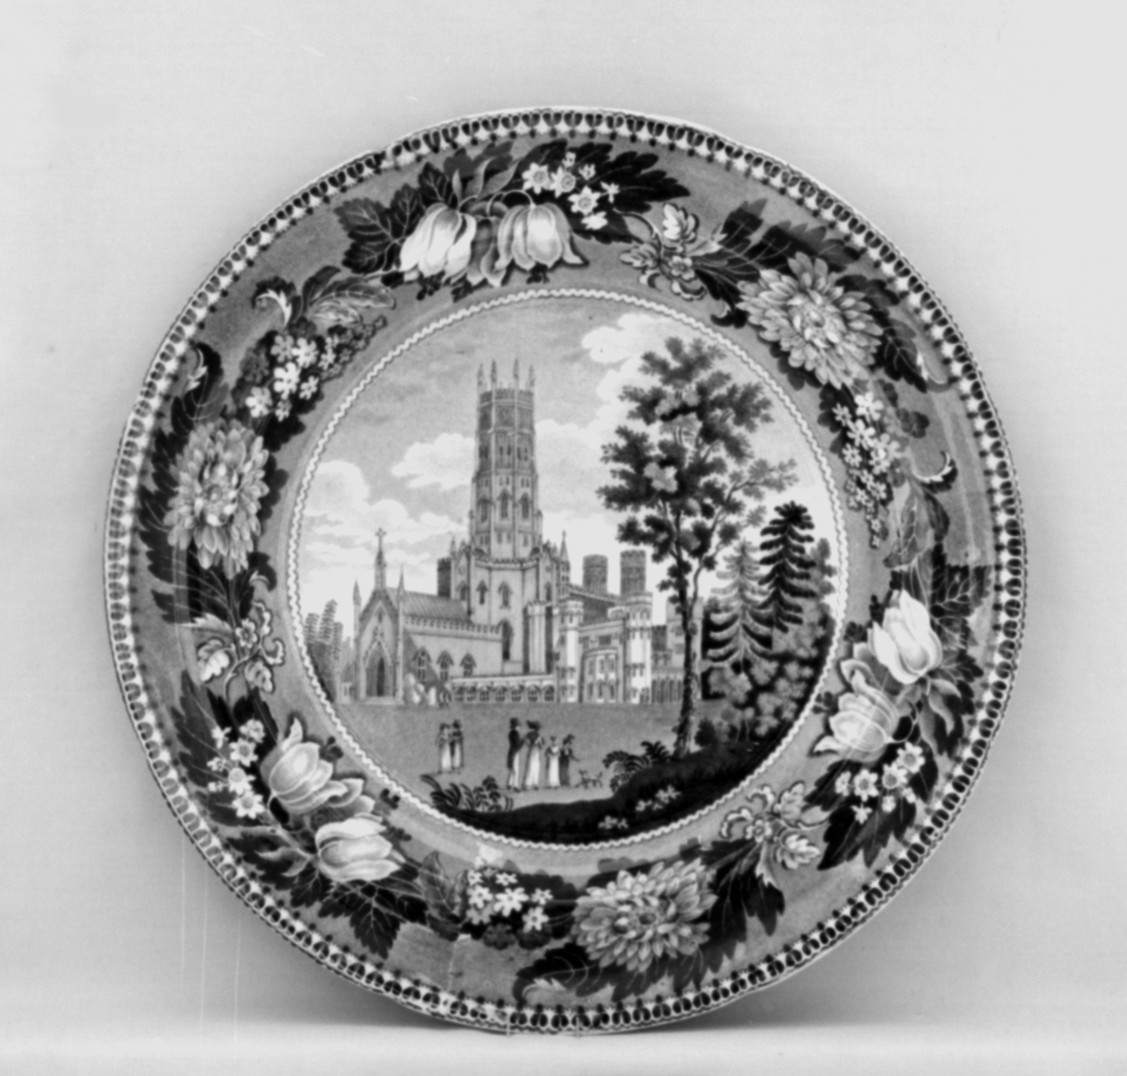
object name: plate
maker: james and ralph clews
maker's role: factory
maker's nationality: british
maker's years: 1813-1836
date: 1801-1900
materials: pottery